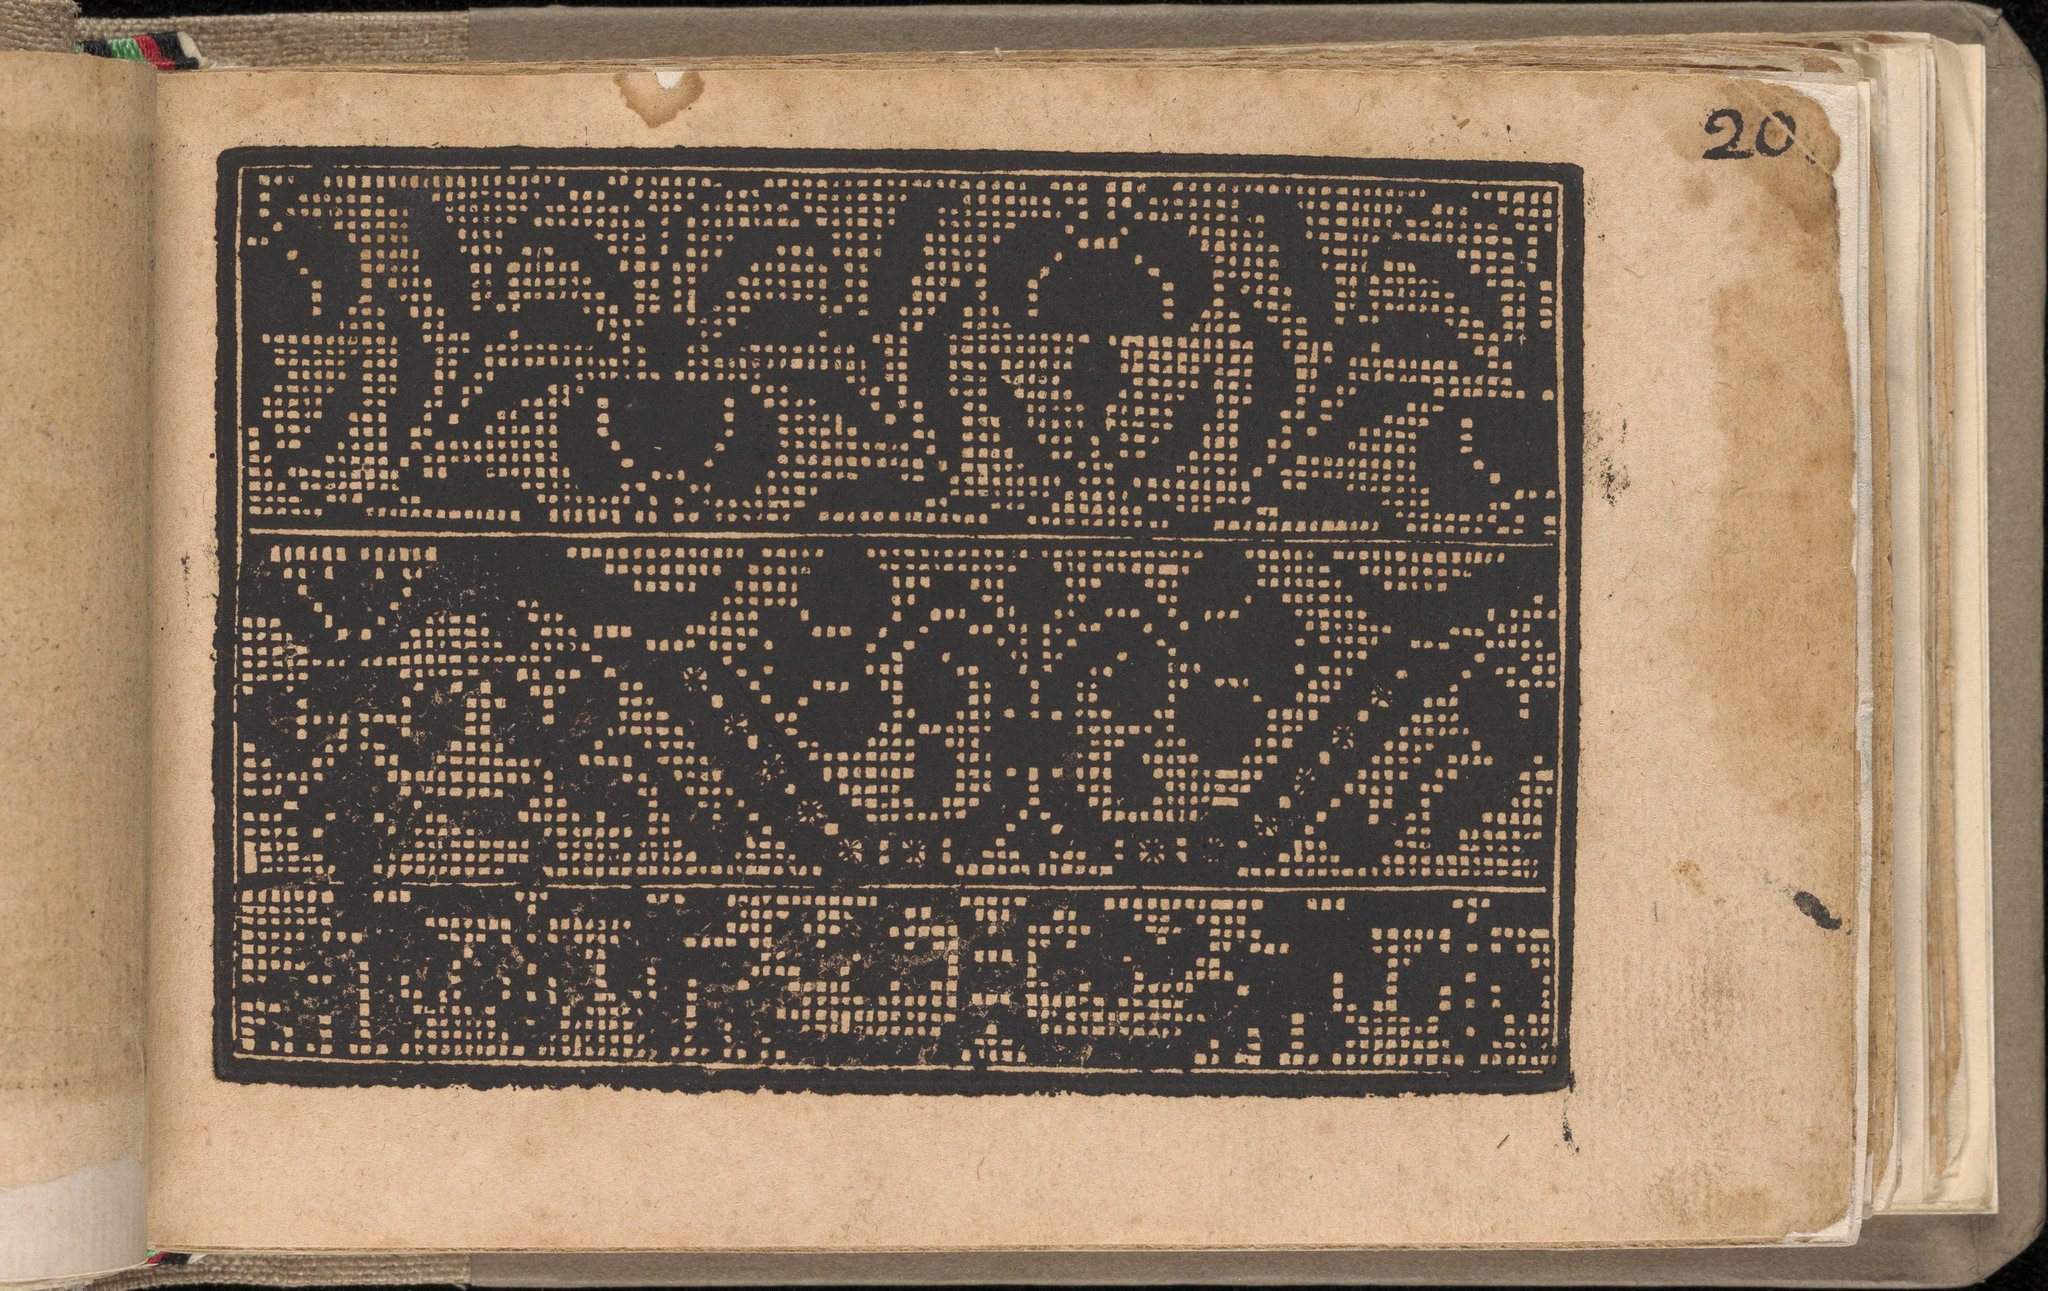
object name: book print ornament architecture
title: Schön newes Modelbuch (Page 20r)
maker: sigismundus latomus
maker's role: publisher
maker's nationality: german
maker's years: 1599-1632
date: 1608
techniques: woodcut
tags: flowers